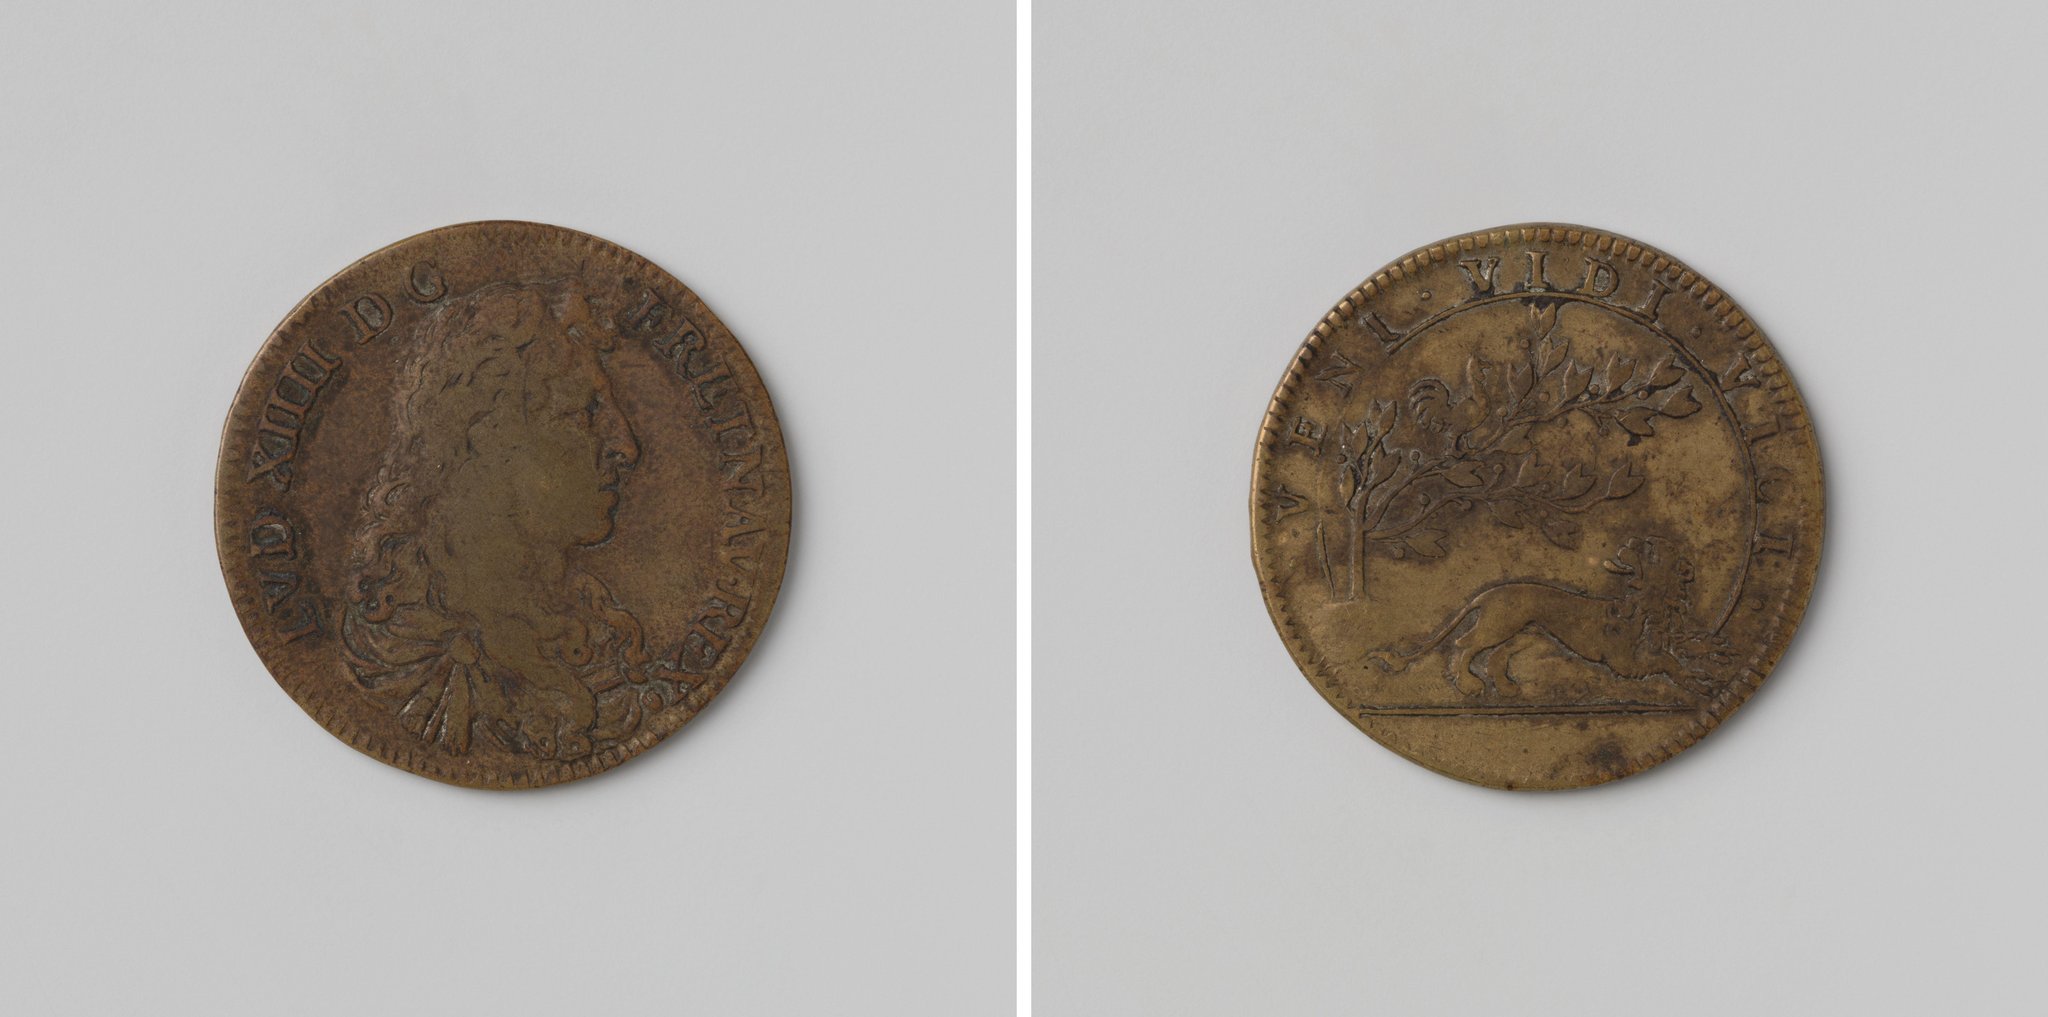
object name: jeton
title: Franche Comte in tien dagen veroverd, rekenpenning geslagen ter ere van Lodewijk XIV, koning van Frankrijk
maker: Anonymous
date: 1668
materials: copper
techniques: striking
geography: france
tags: lodewijk xiv (koning van frankrijk)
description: Koperen penning. Voorzijde: borststuk man binnen omschrift. Keerzijde: leeuw, vluchtend voor kraaiende haan, zittend in laurierboom binnen omschrift